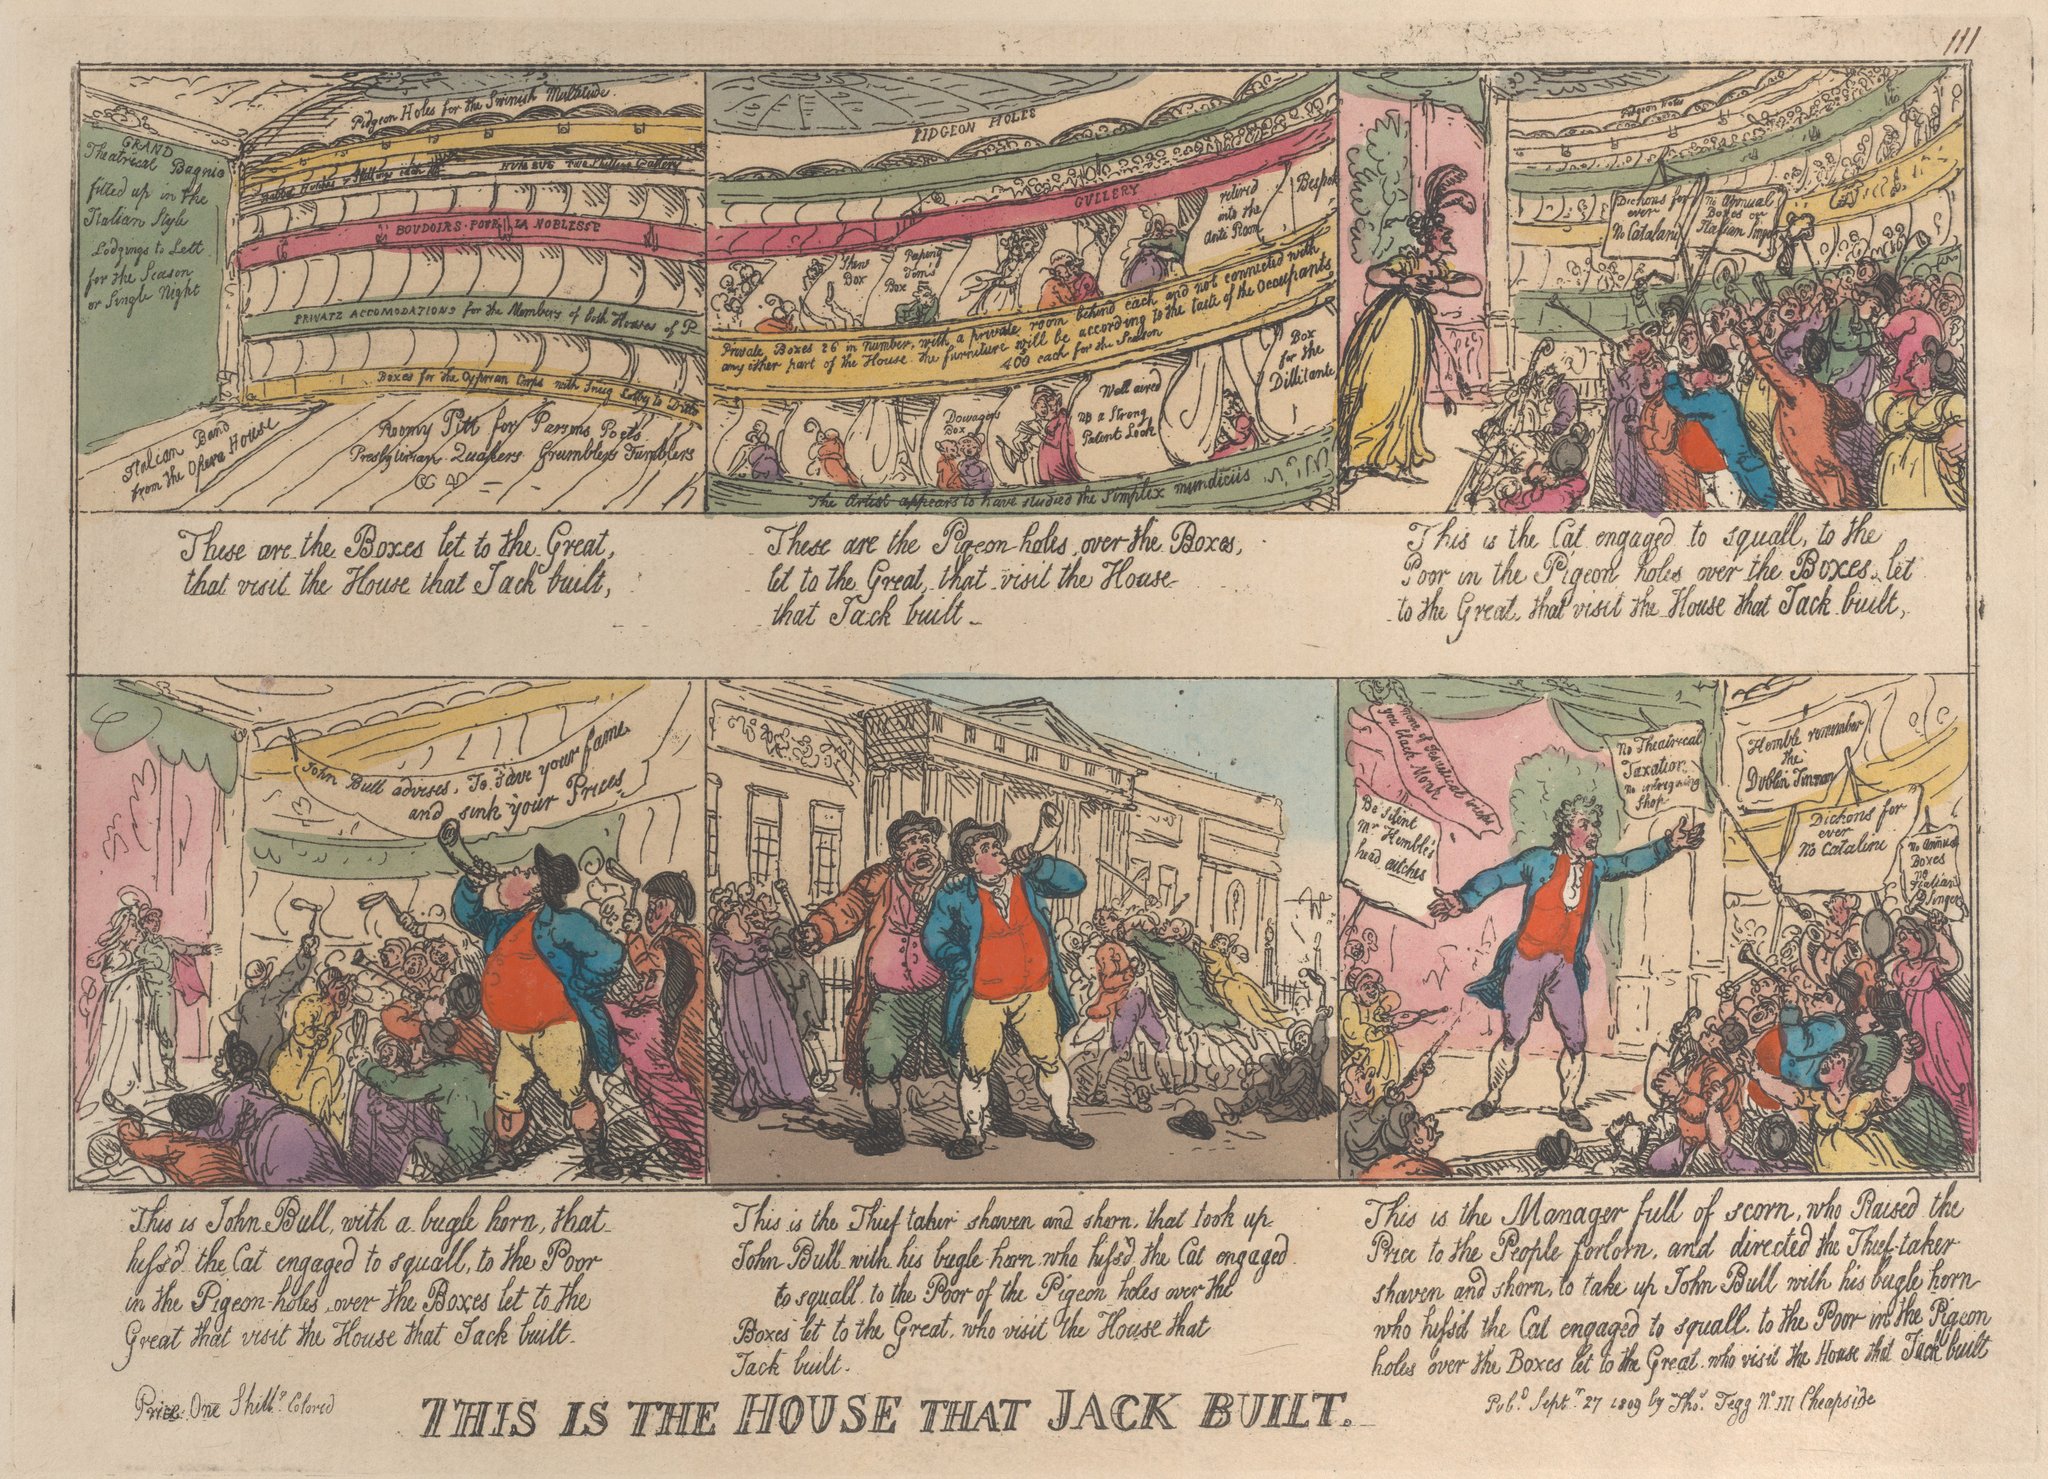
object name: print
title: This is the House that Jack Built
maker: thomas rowlandson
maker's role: artist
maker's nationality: british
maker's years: 1757-1827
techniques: etching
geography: london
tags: satire,politics